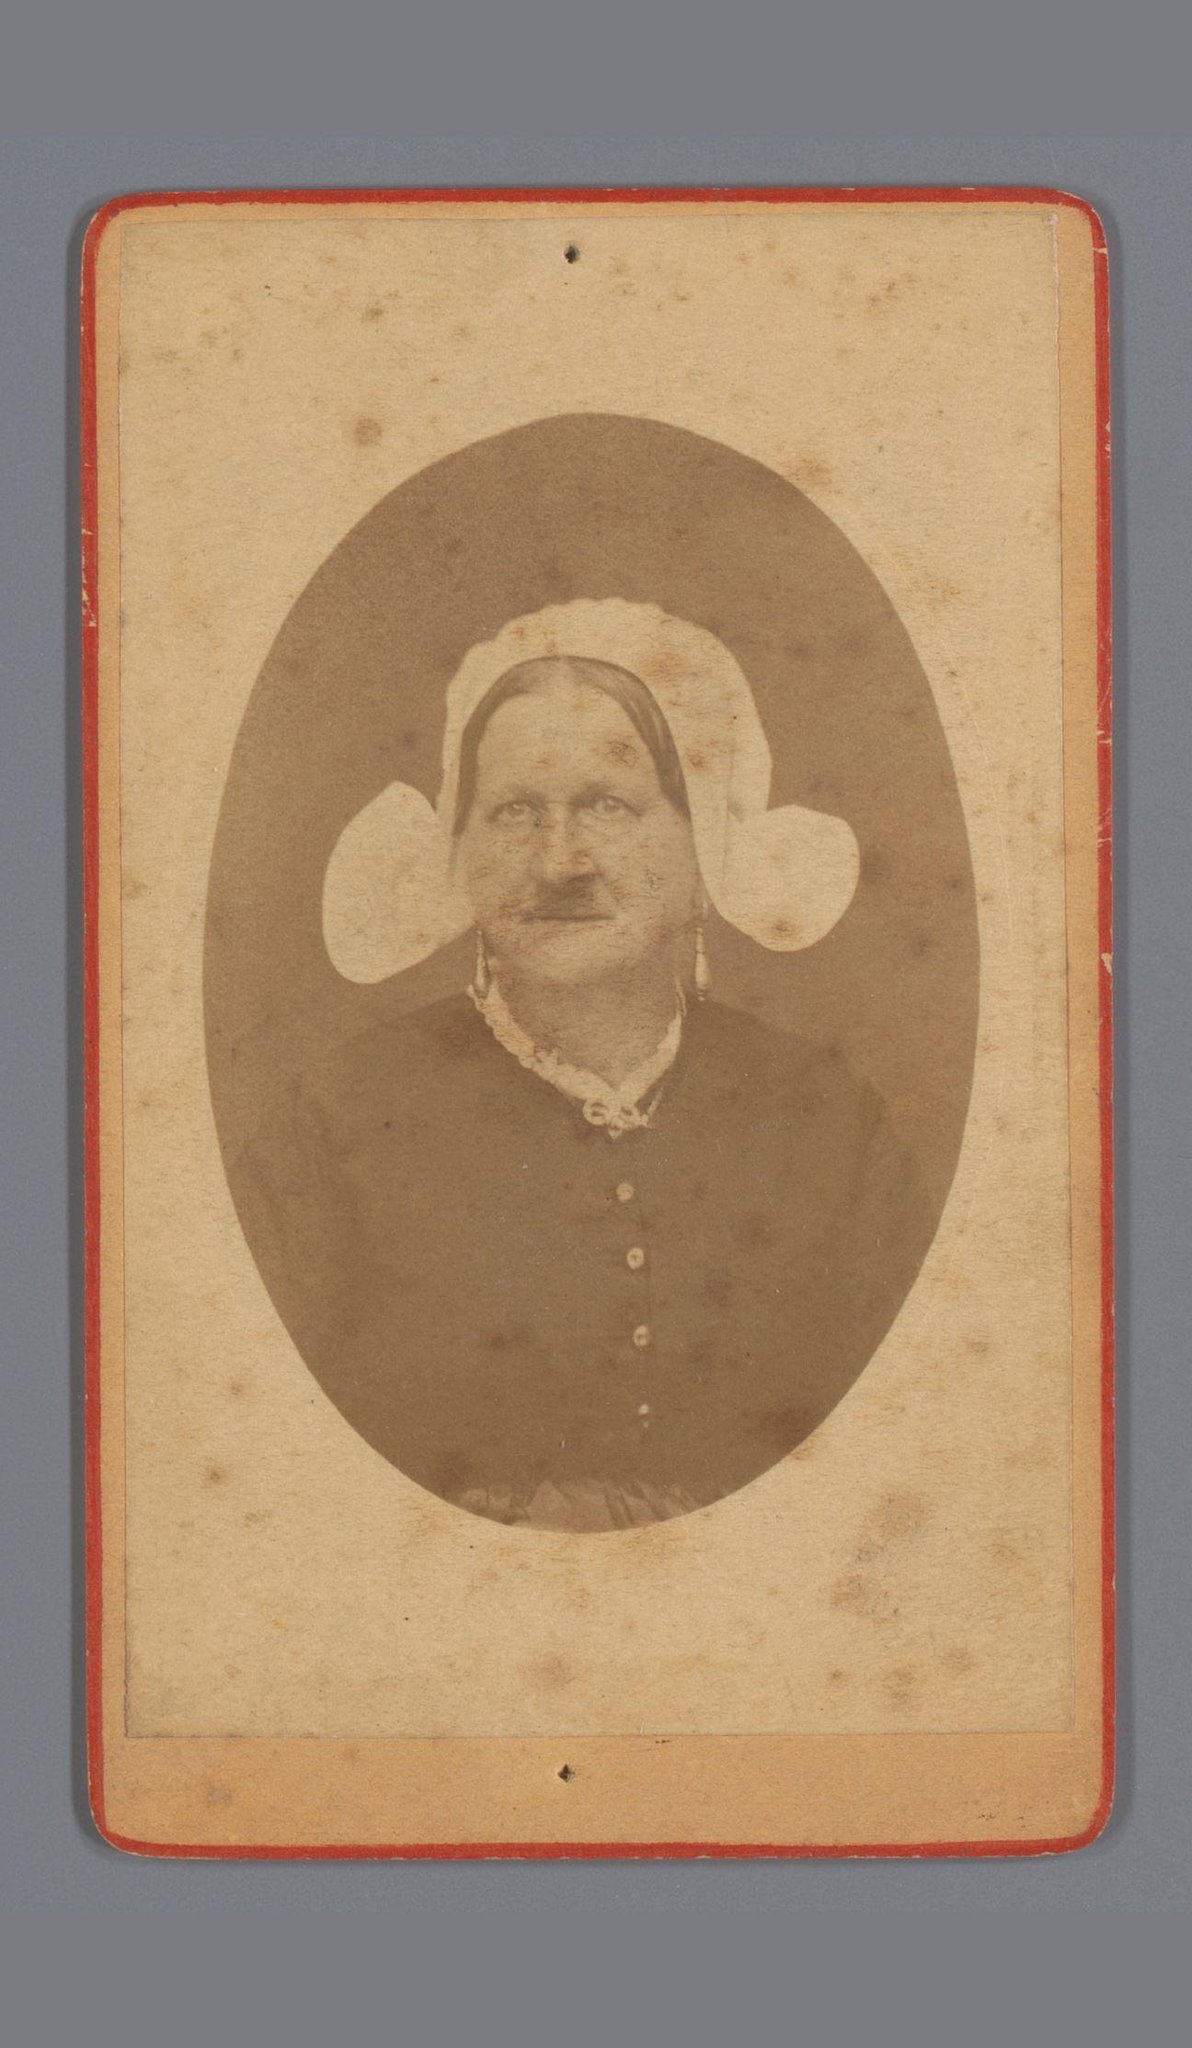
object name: photograph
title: Portret van een onbekende oude vrouw met hoofddeksel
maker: j. van os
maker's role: fotograaf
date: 1855-1885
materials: cardboard, paper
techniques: albumen print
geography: antwerp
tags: adult woman, head-gear: cap, anonymous historical person portrayed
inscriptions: address: ‘ANTWERPEN,/ Beggijnenstraat Rue des Béguines/ No 46/ ANVERS.’